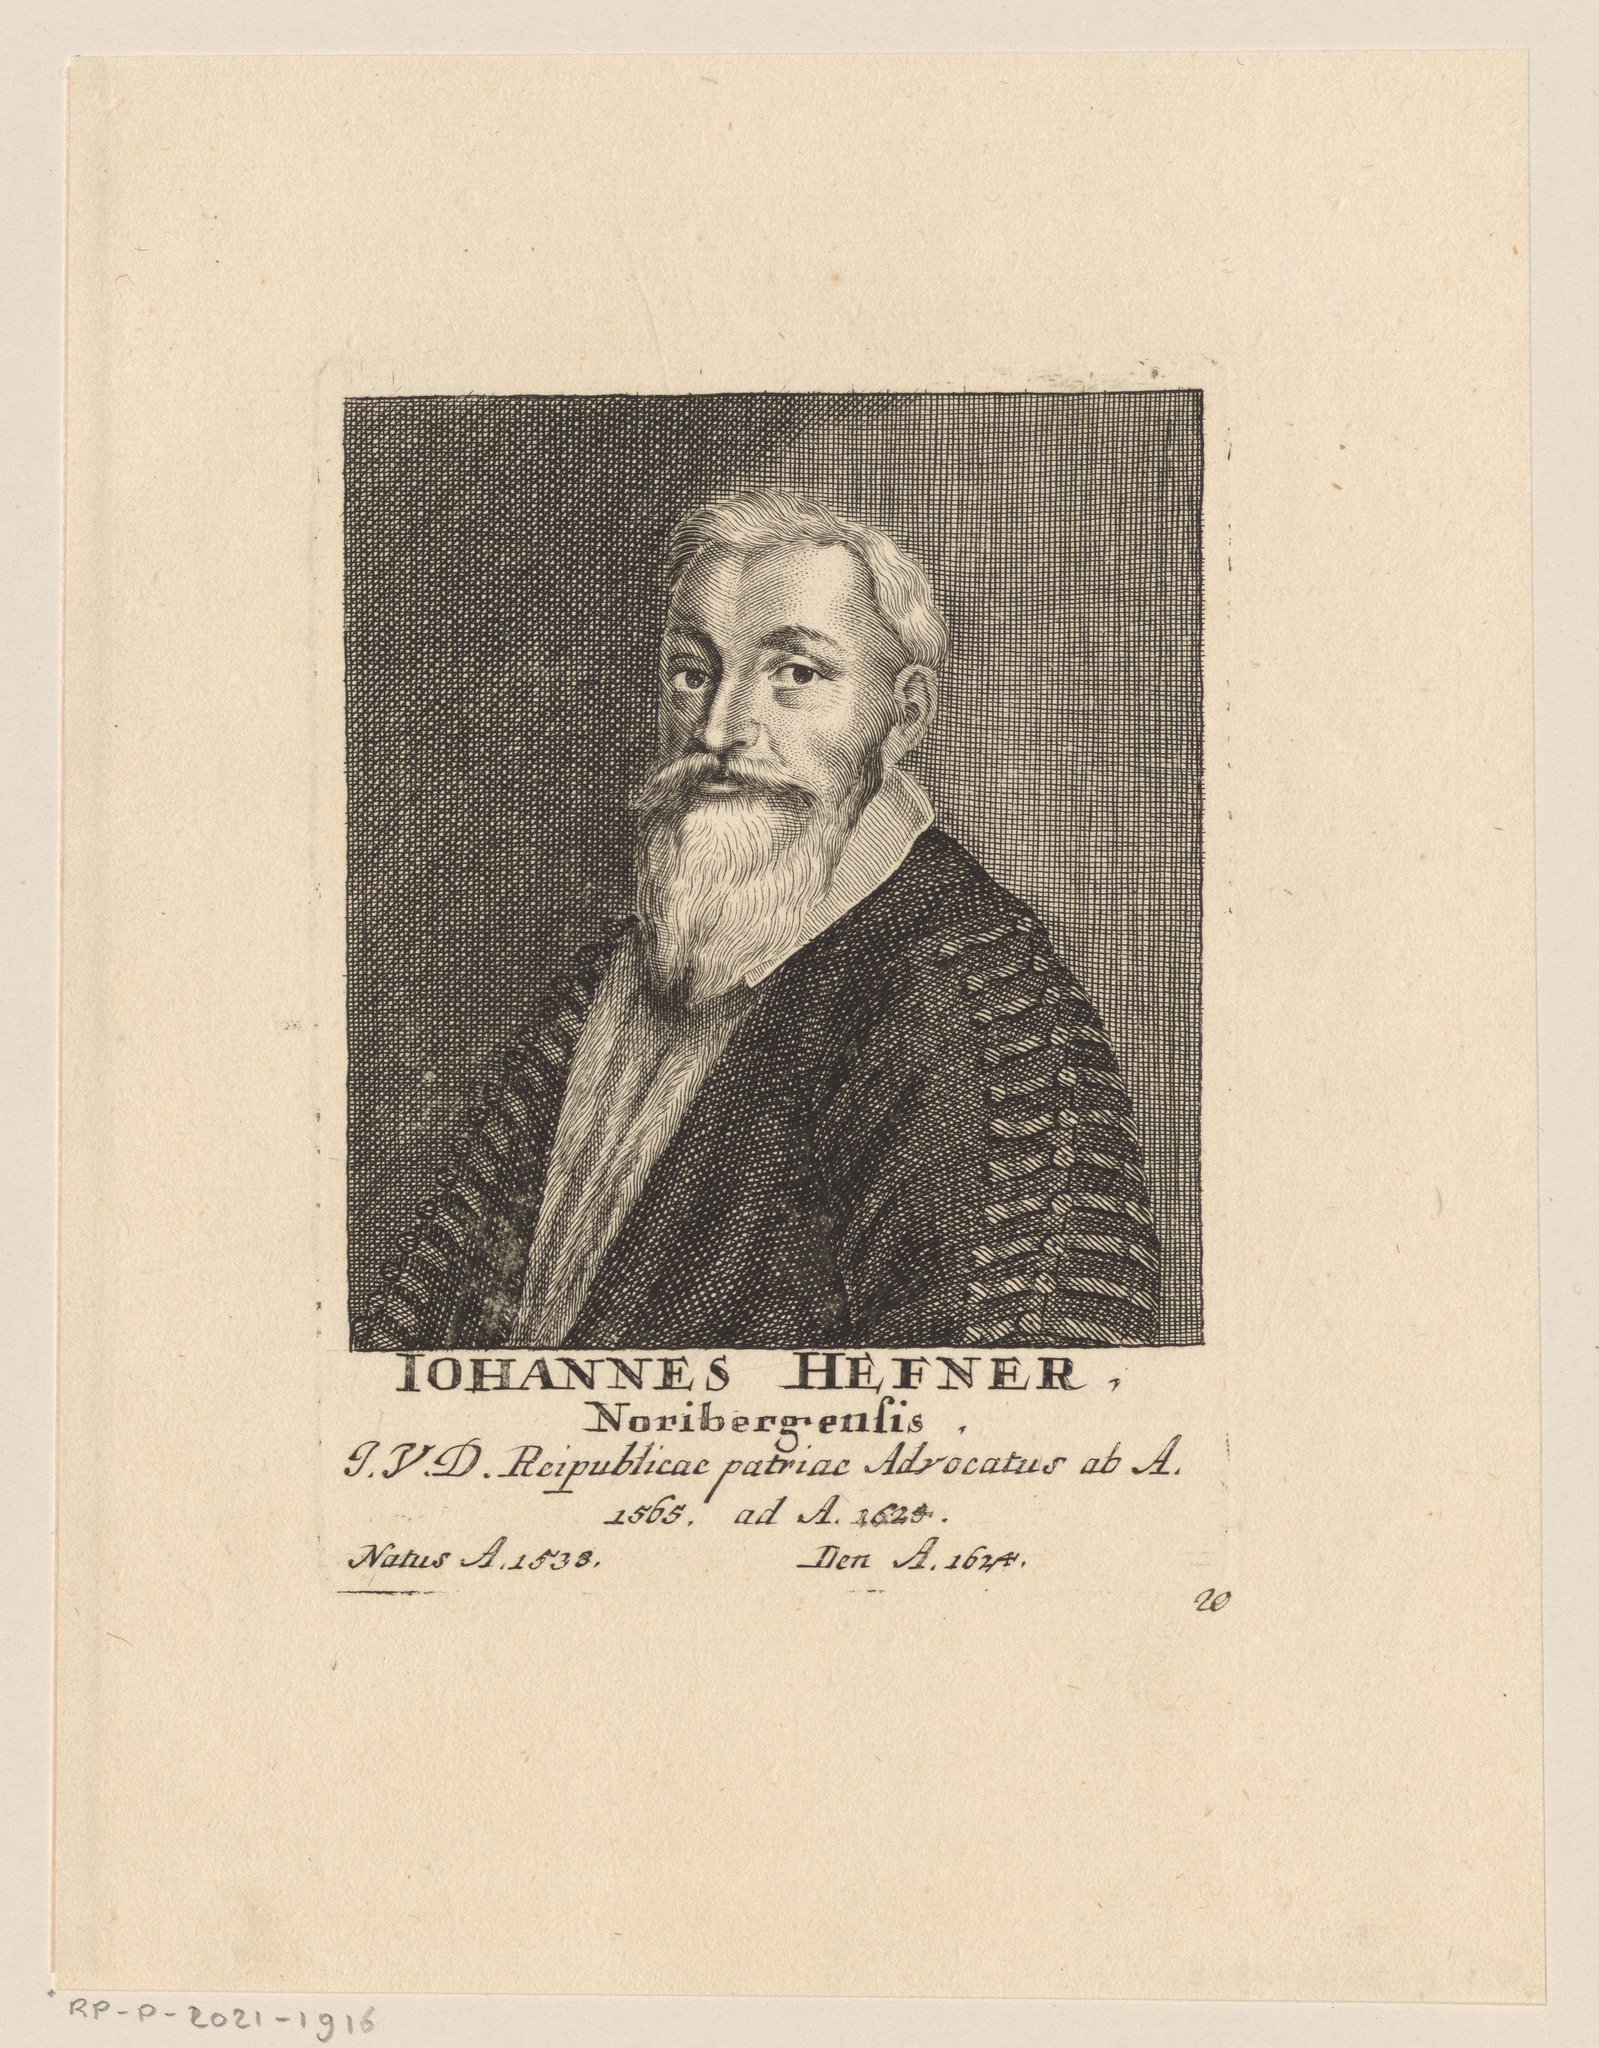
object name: book illustration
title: Portret van Johann Hefner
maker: Anonymous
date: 1725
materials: paper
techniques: engraving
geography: nuremberg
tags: historical persons, lawyer, attorney at law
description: Prent uit: Roth-Scholtz, Friedrich. Icones Virorum de republica litteraria optime meritorum. Neurennberg en Altdorf: erven Johann Daniel Tauber, 1725, dl. 2.